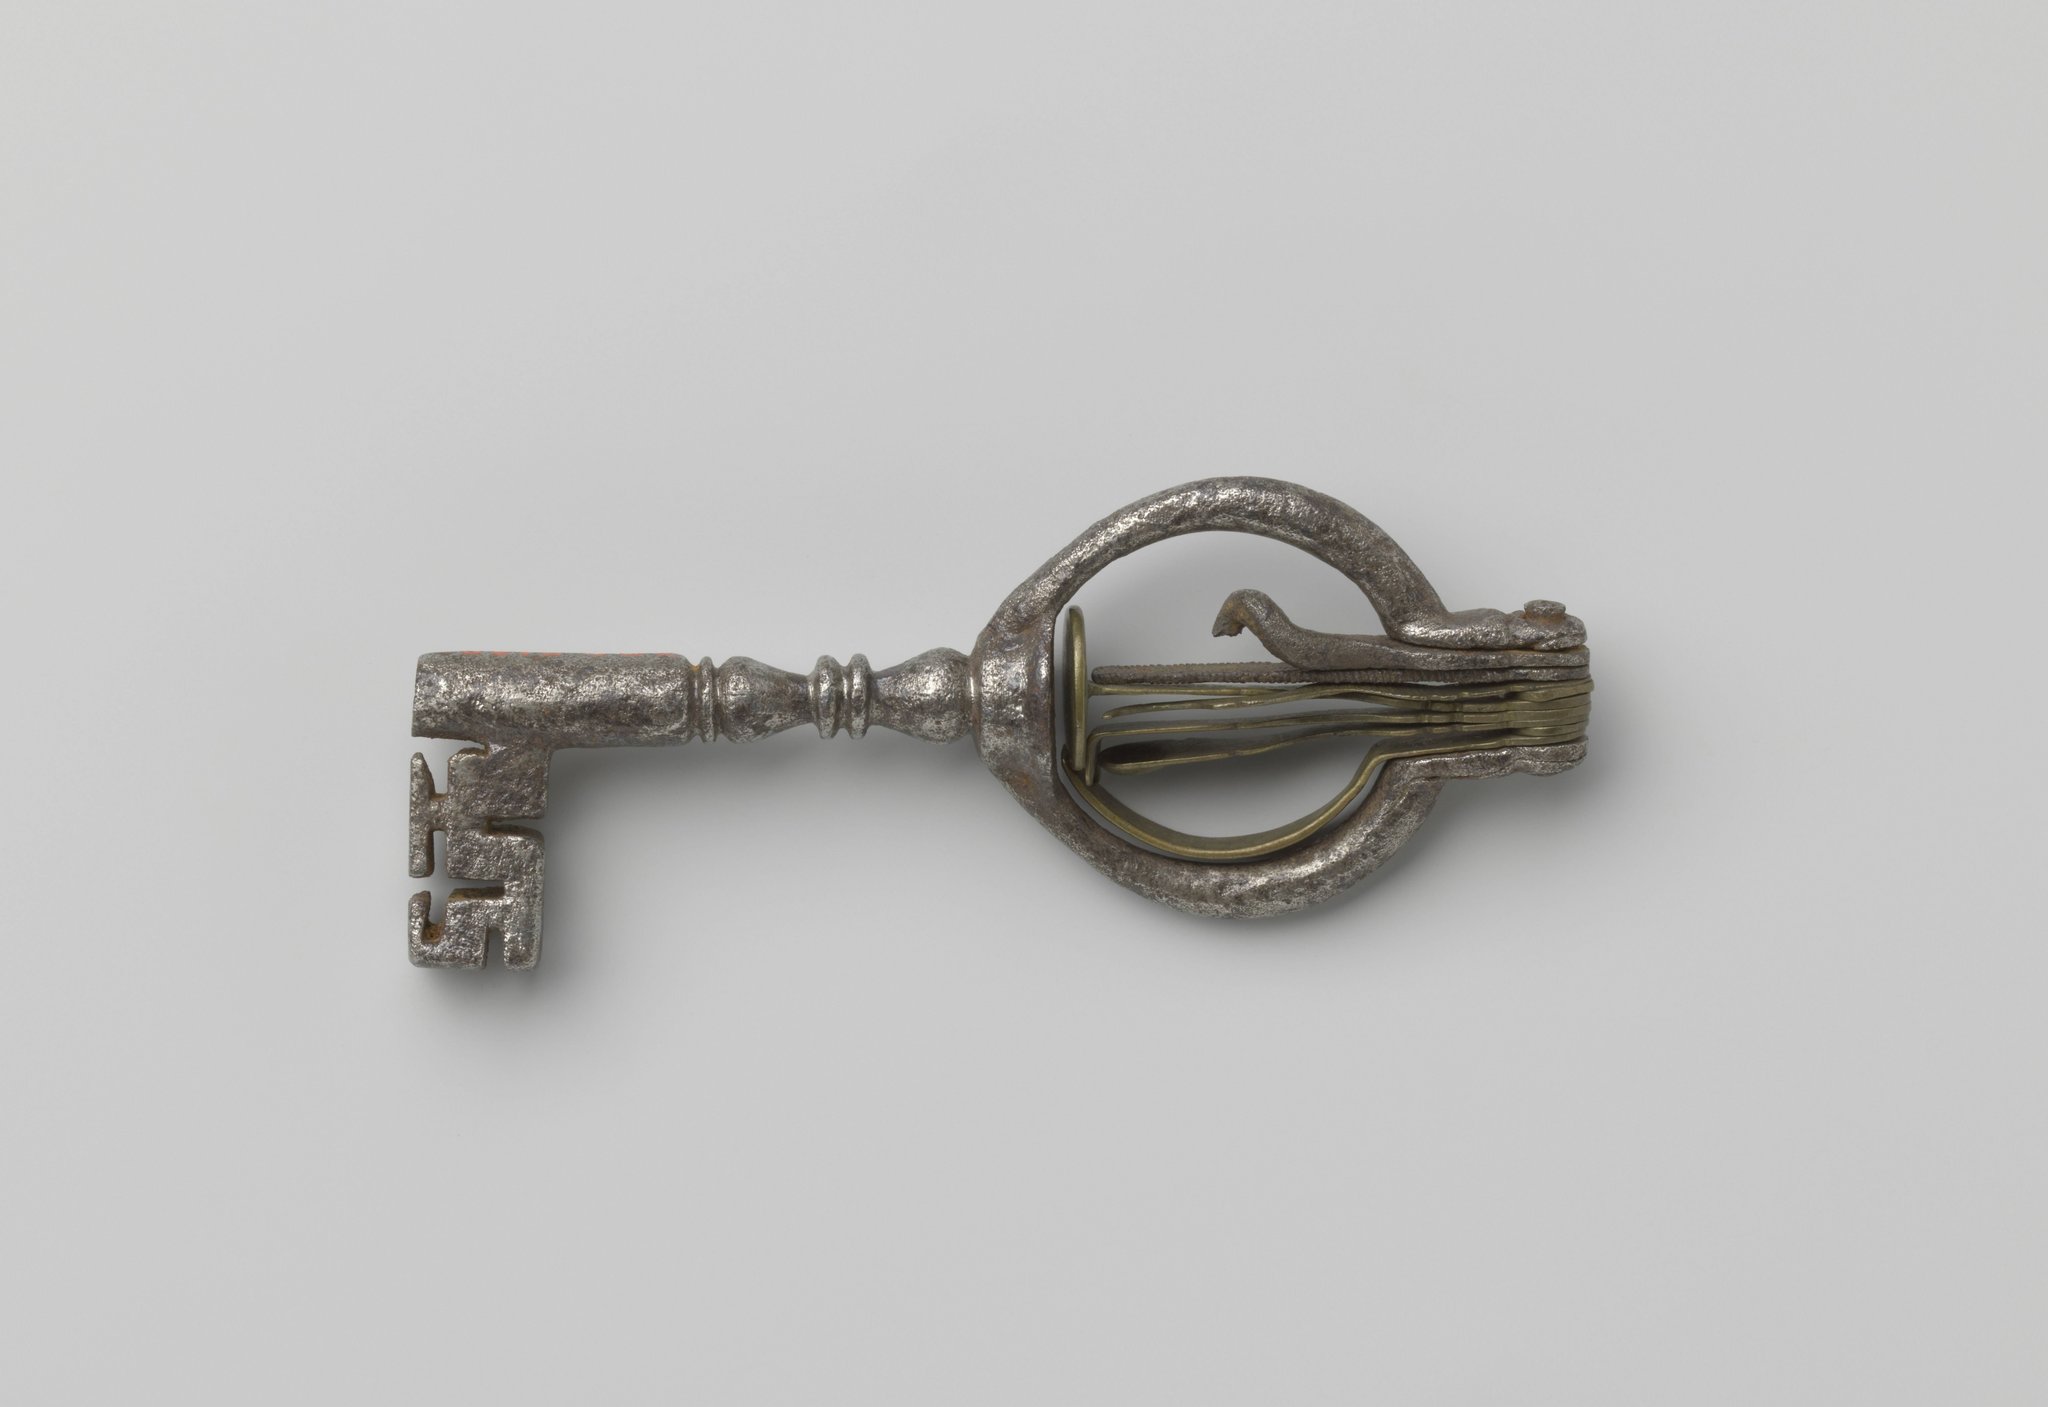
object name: key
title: Sleutel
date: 1700-1800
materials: iron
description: Sleutel met in de ronde greep een reis- en rookgarnituur; o.a. pijpstamper, krabber, kurketrekker etc. De schacht is zandlopervormig geprofileerd.